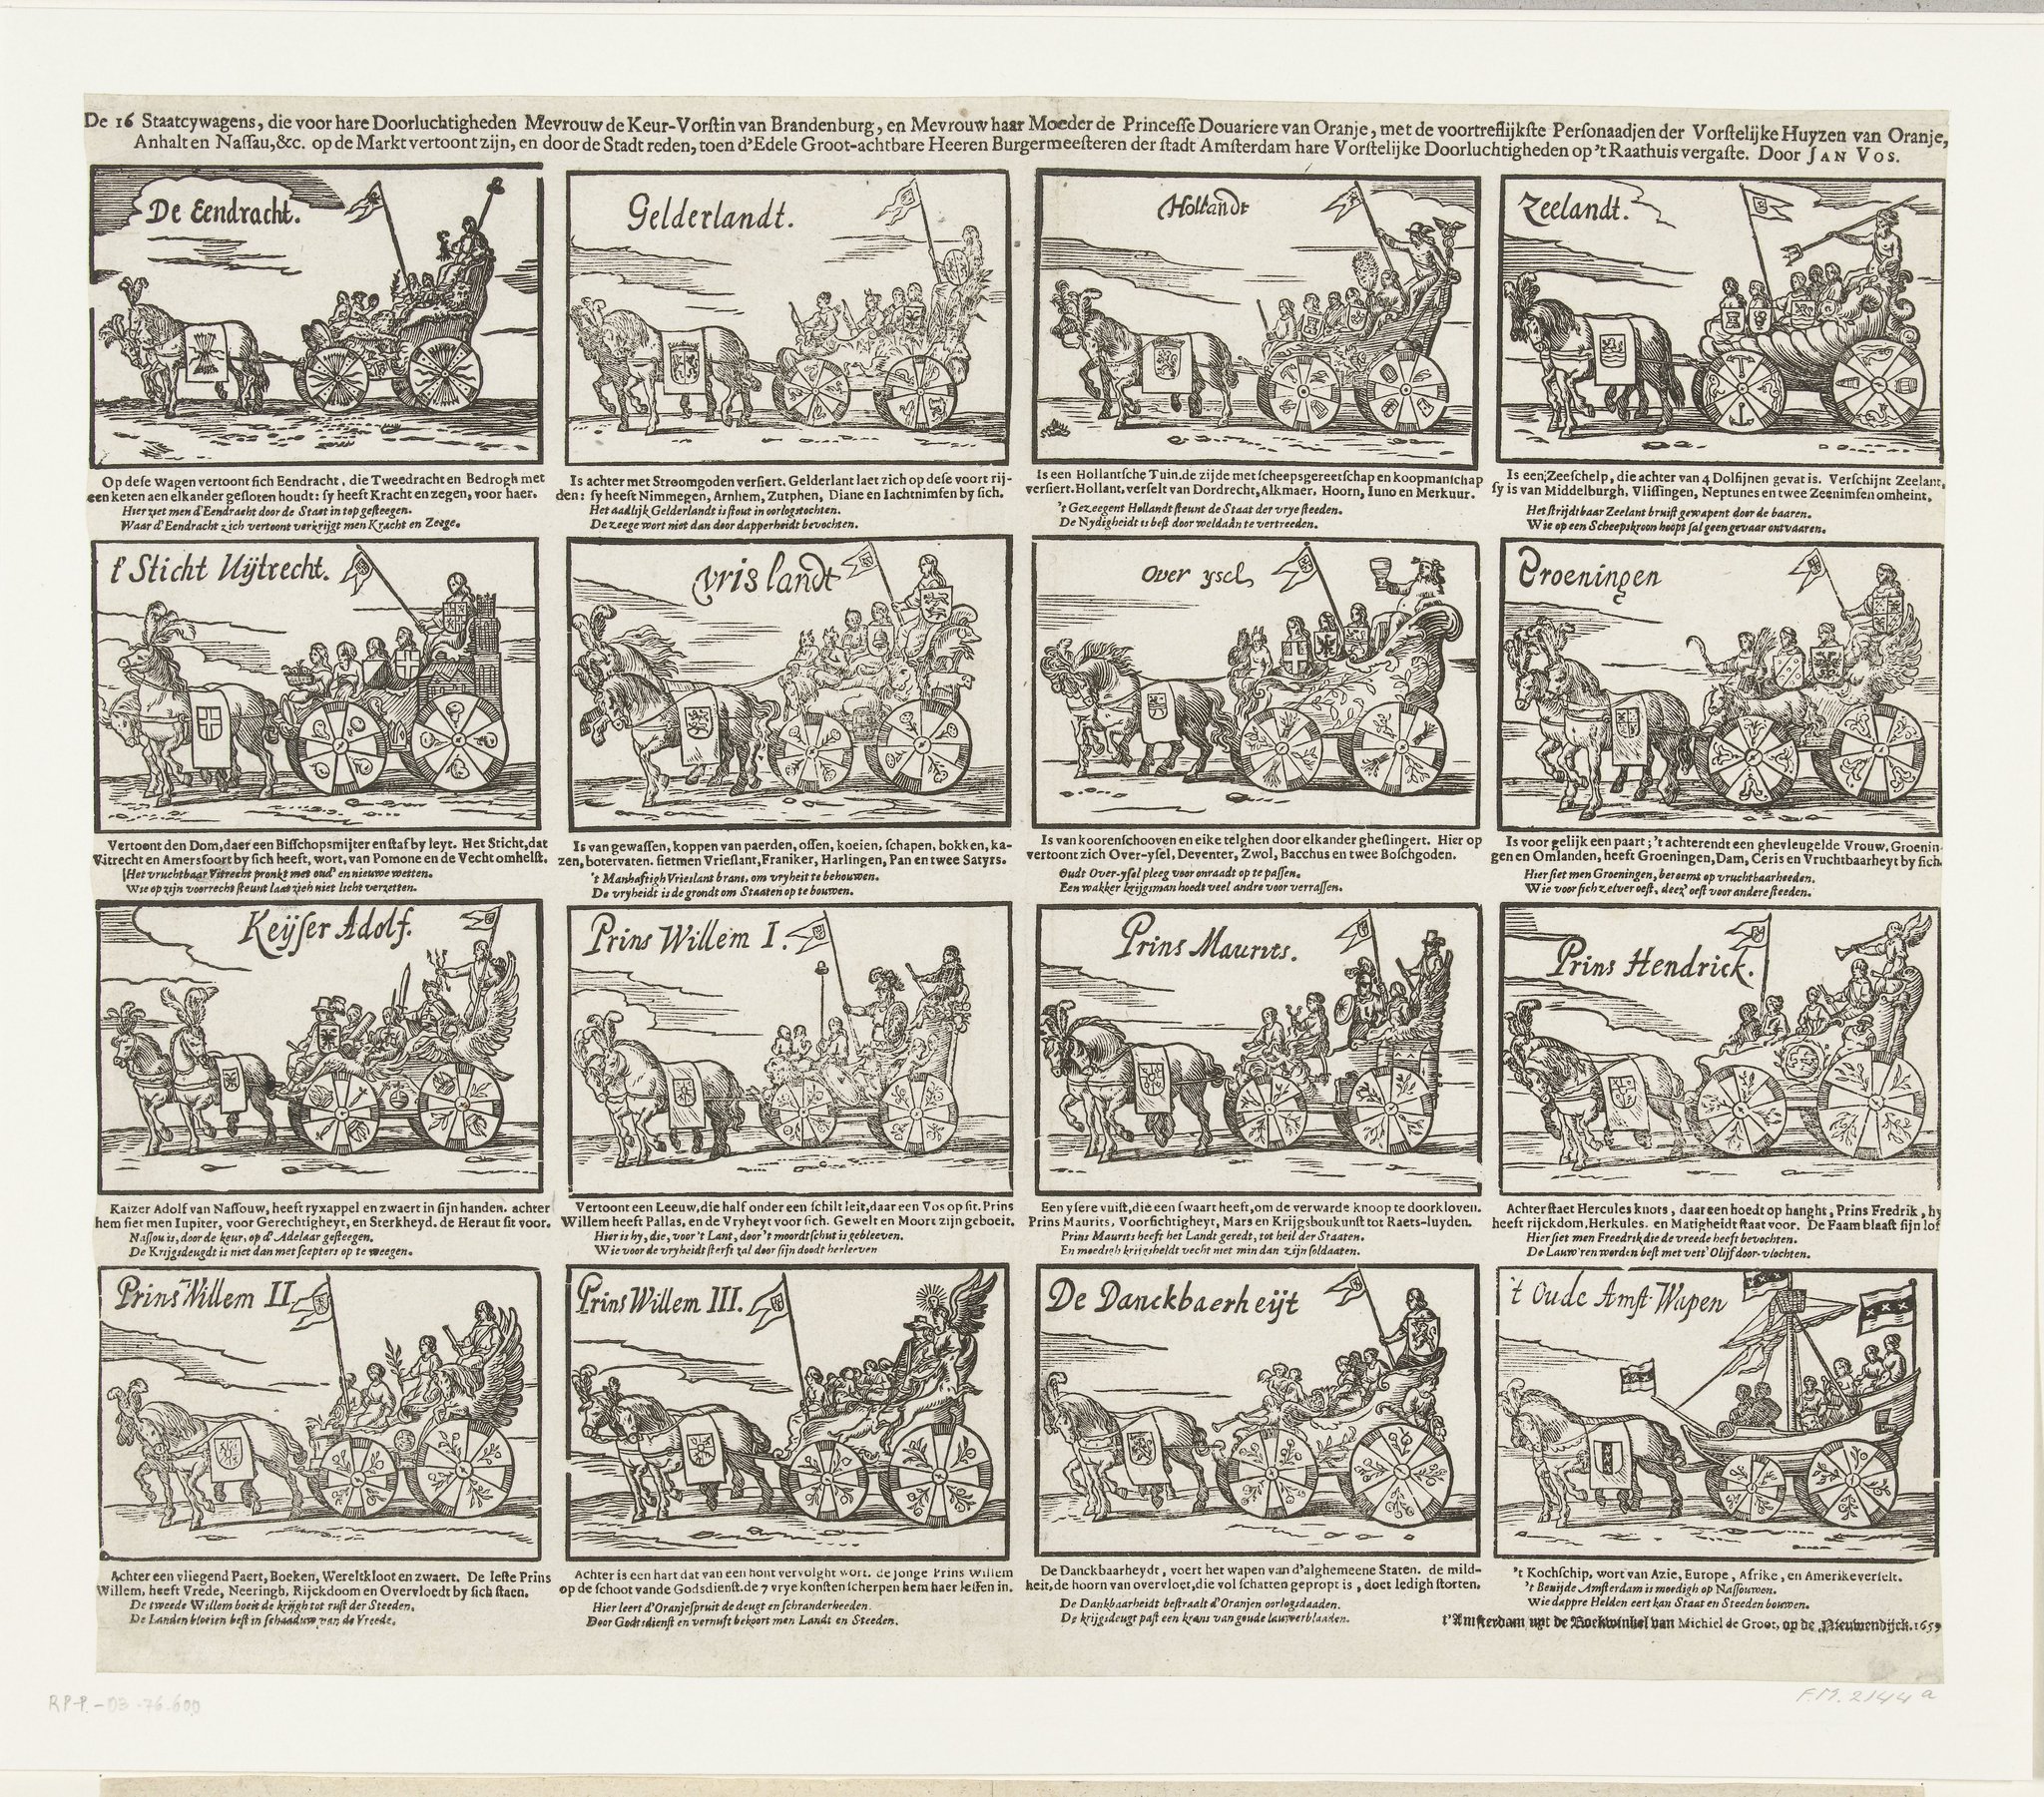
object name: print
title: De 16 Staatcywagens, die voor hare Doorluchtigheden Mevrouw de Keur-Vorstin van Brandenburg, en Mevrouw haar Moeder de Princesse Douariere van Oranje, met de voortreflijkste Personaadjen der Vorstelijke Huyzen van Oranje, Anhalt en Nassau, &c. op de Marckt vertoont zijn, en door de Stadt reden, toen d'Edele Groot-achtbare Heeren Burgermeesteren der stadt Amsterdam hare Vorstelijke Doorluchtigheden op 't Raathuis vergaste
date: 1659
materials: paper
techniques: letterpress printing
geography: northern netherlands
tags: amalia of solms-braunfels, the hague, berlin, louise henriëtte (prinses van oranje), triumphal entry and public reception, pageant, 'entrée solennelle', 'joyeuse entrée', roman chariot, quadriga ~ triumph, amsterdam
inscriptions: date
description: Blad met de zestien staatsiewagens gebruikt bij het bezoek van de Louise Henriëtte, gravin van Nassau en keurvorstin van Brandenburg en haar moeder Amalia van Solms aan Amsterdam, augustus 1659. Zestien praalwagens waarvan zeven de provincies verbeelden, twee de begrippen Eendracht en Dankbaarheid, zes voorouders en de laatste kar in de vorm van het oude koggeschip van Amsterdam. Onder elk plaatje twee tweeregelige versjes.